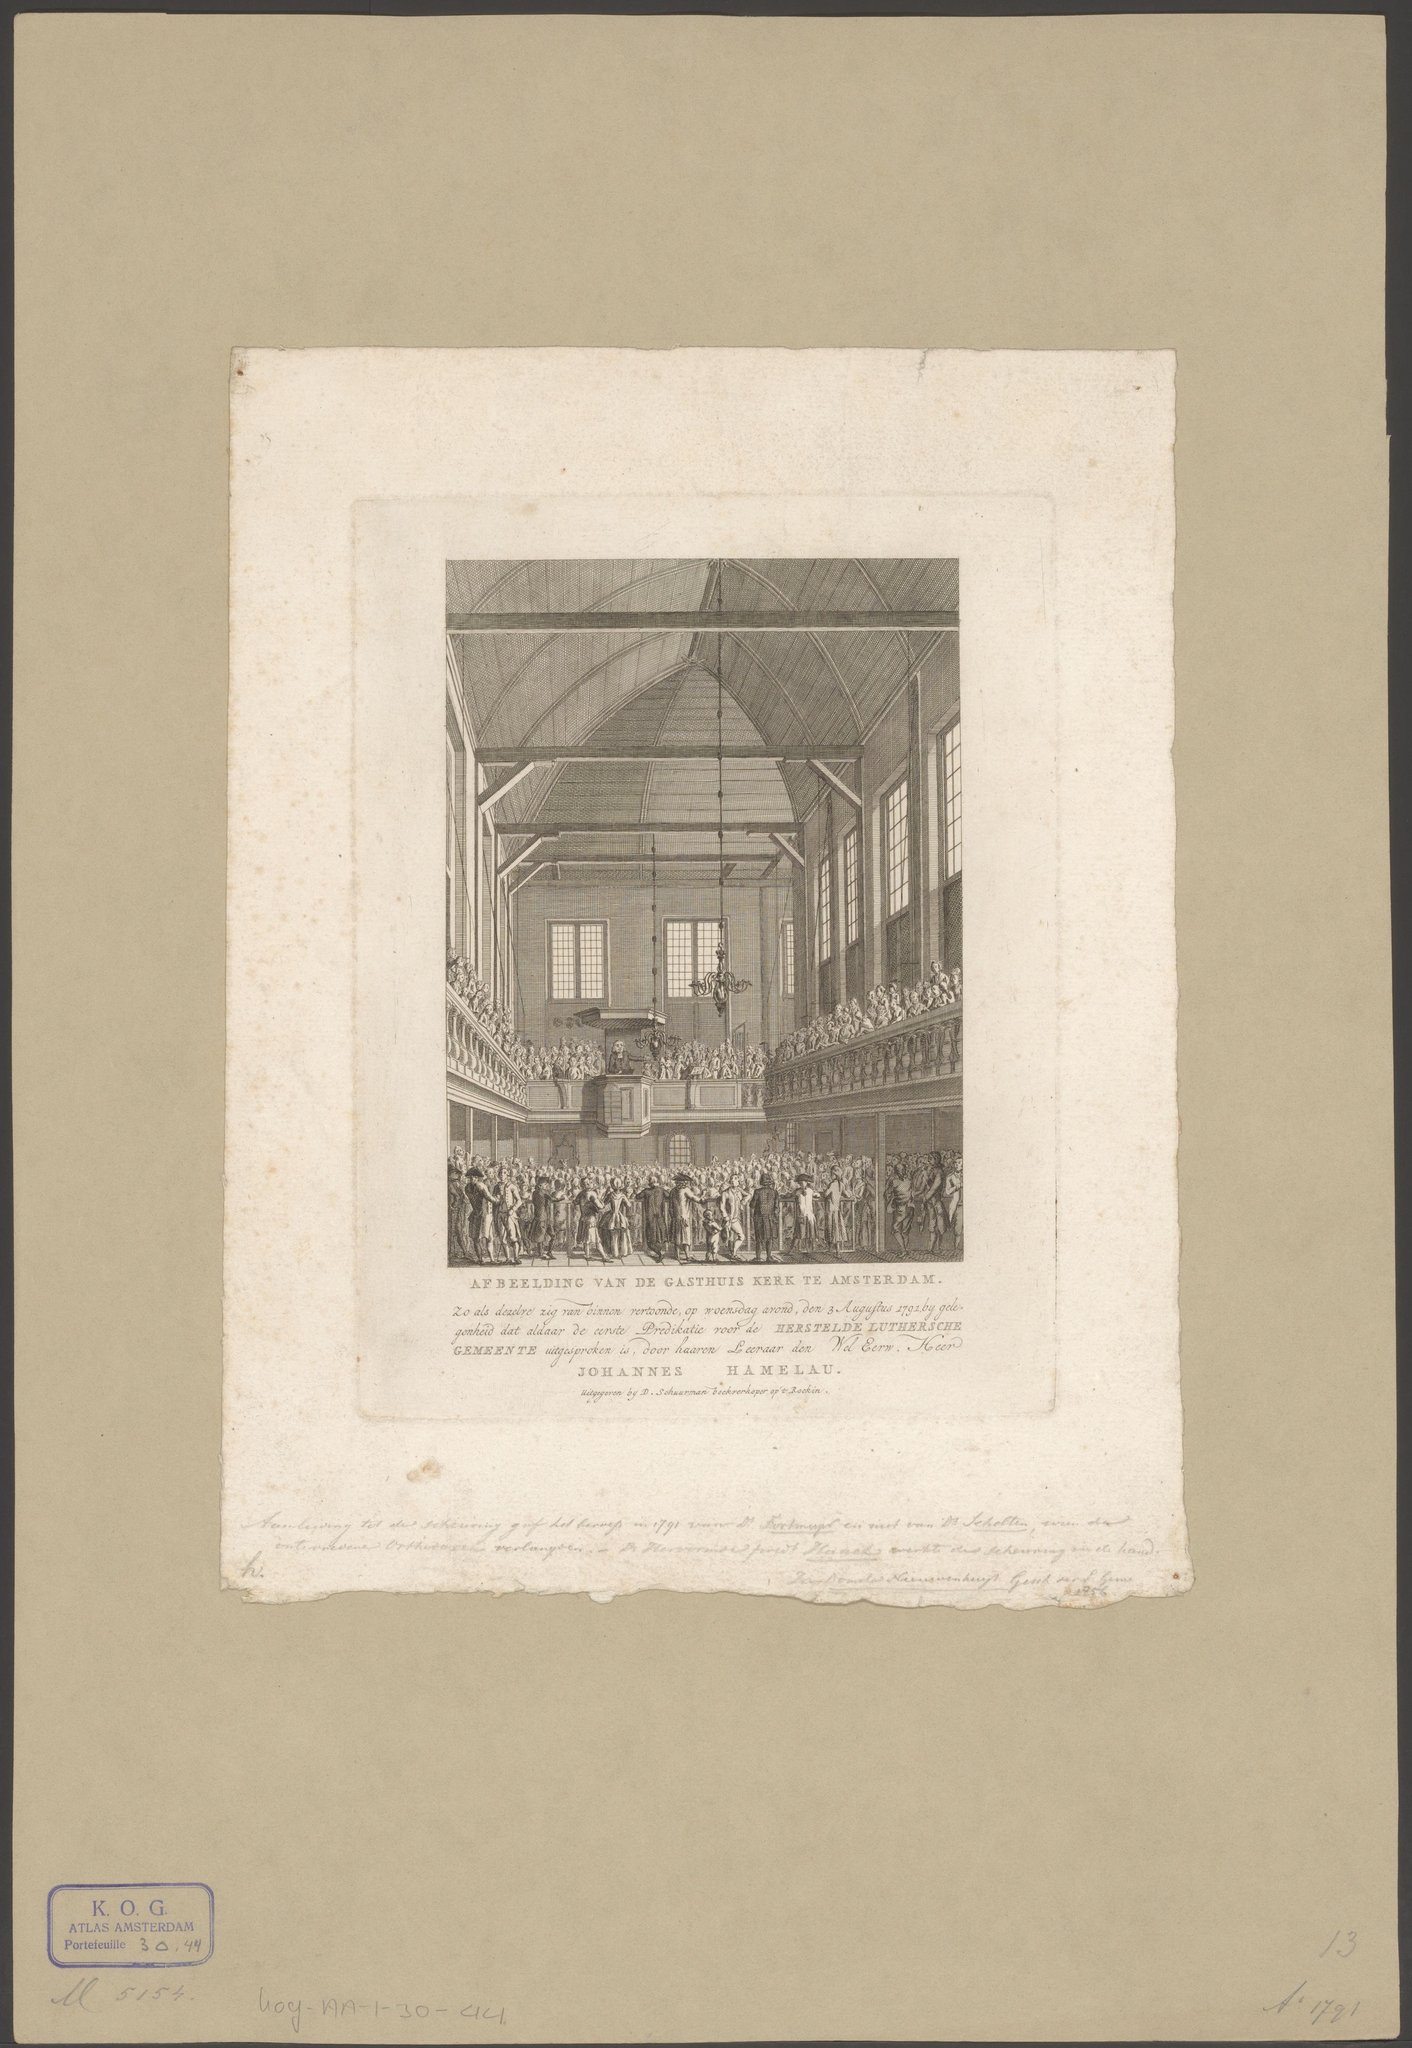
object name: print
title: Afbeelding van de Gasthuis Kerk te Amsterdam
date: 1791-1793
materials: paper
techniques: engraving, etching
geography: northern netherlands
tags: amsterdam, interior of church, sermon ~ protestant service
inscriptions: collector's mark: Lugt 1641b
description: Onderwerpsrubriek binnen de Atlas Amsterdam: Kerkwezen: Hervormde Gemeente: Gasthuiskerk.